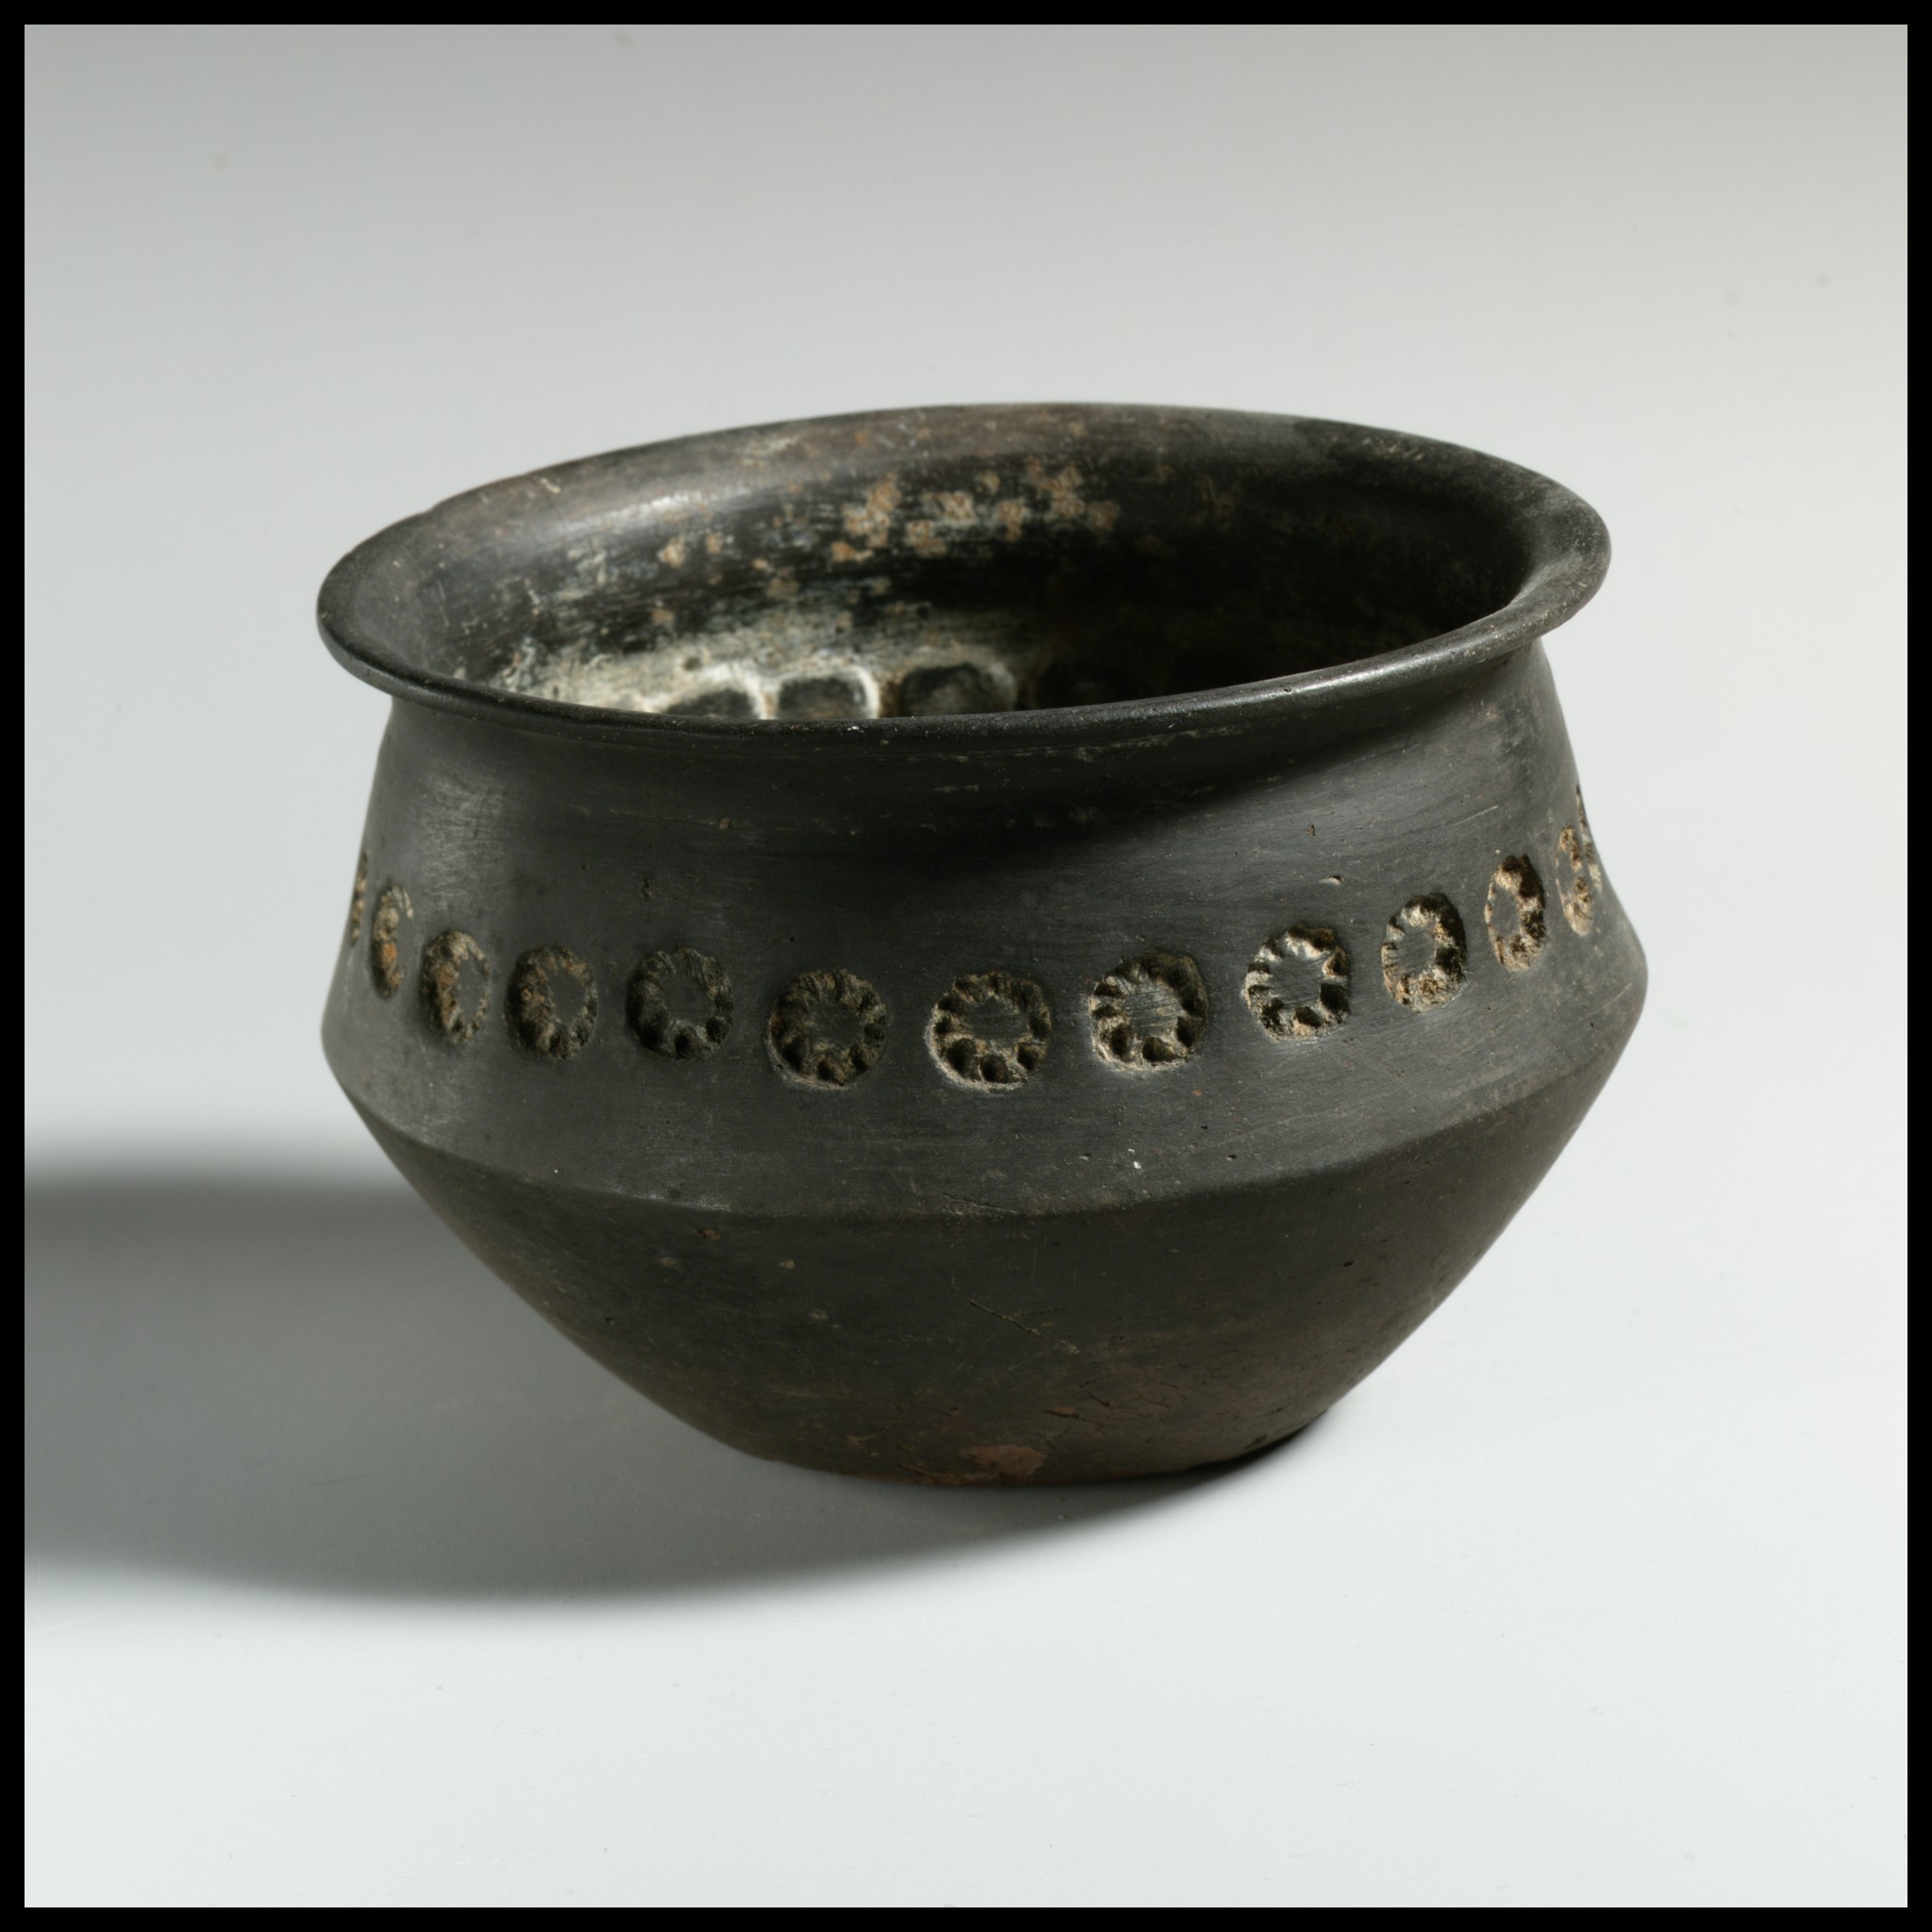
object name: vase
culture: roman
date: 670 BCE-330 CE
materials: terracotta